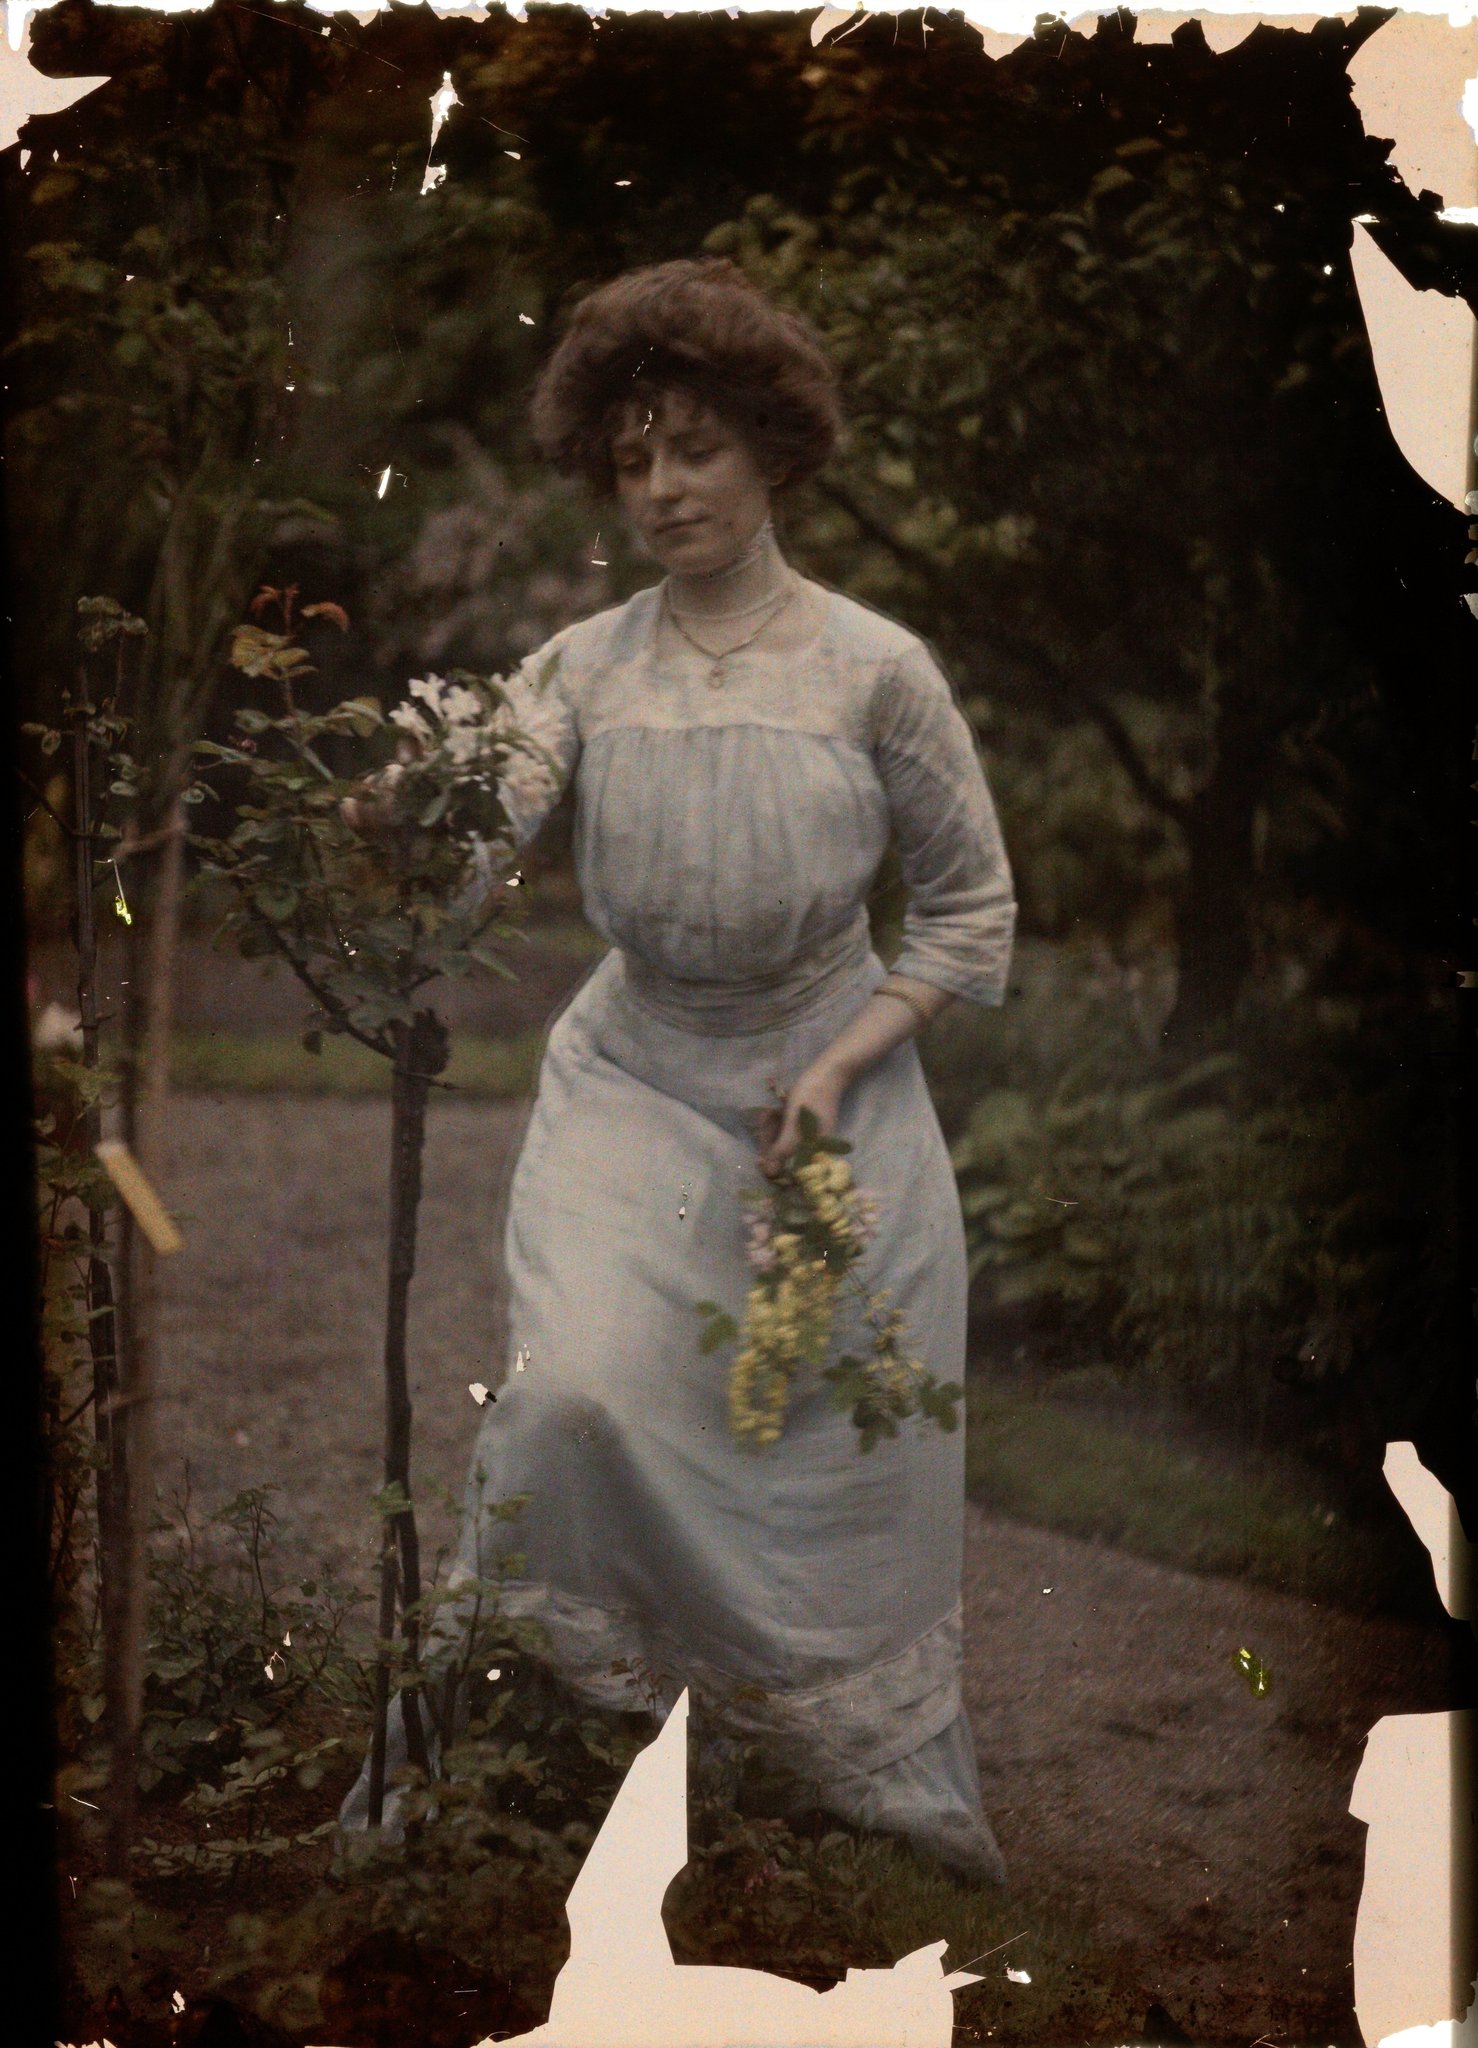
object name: photograph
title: Vrouw in tuin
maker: johannes hendrikus antonius maria lutz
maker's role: fotograaf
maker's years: -1916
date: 1907-1916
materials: glass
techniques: autochrome process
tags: picking flowers, garden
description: Vrouw in tuin staande bij een bloemenstruik.